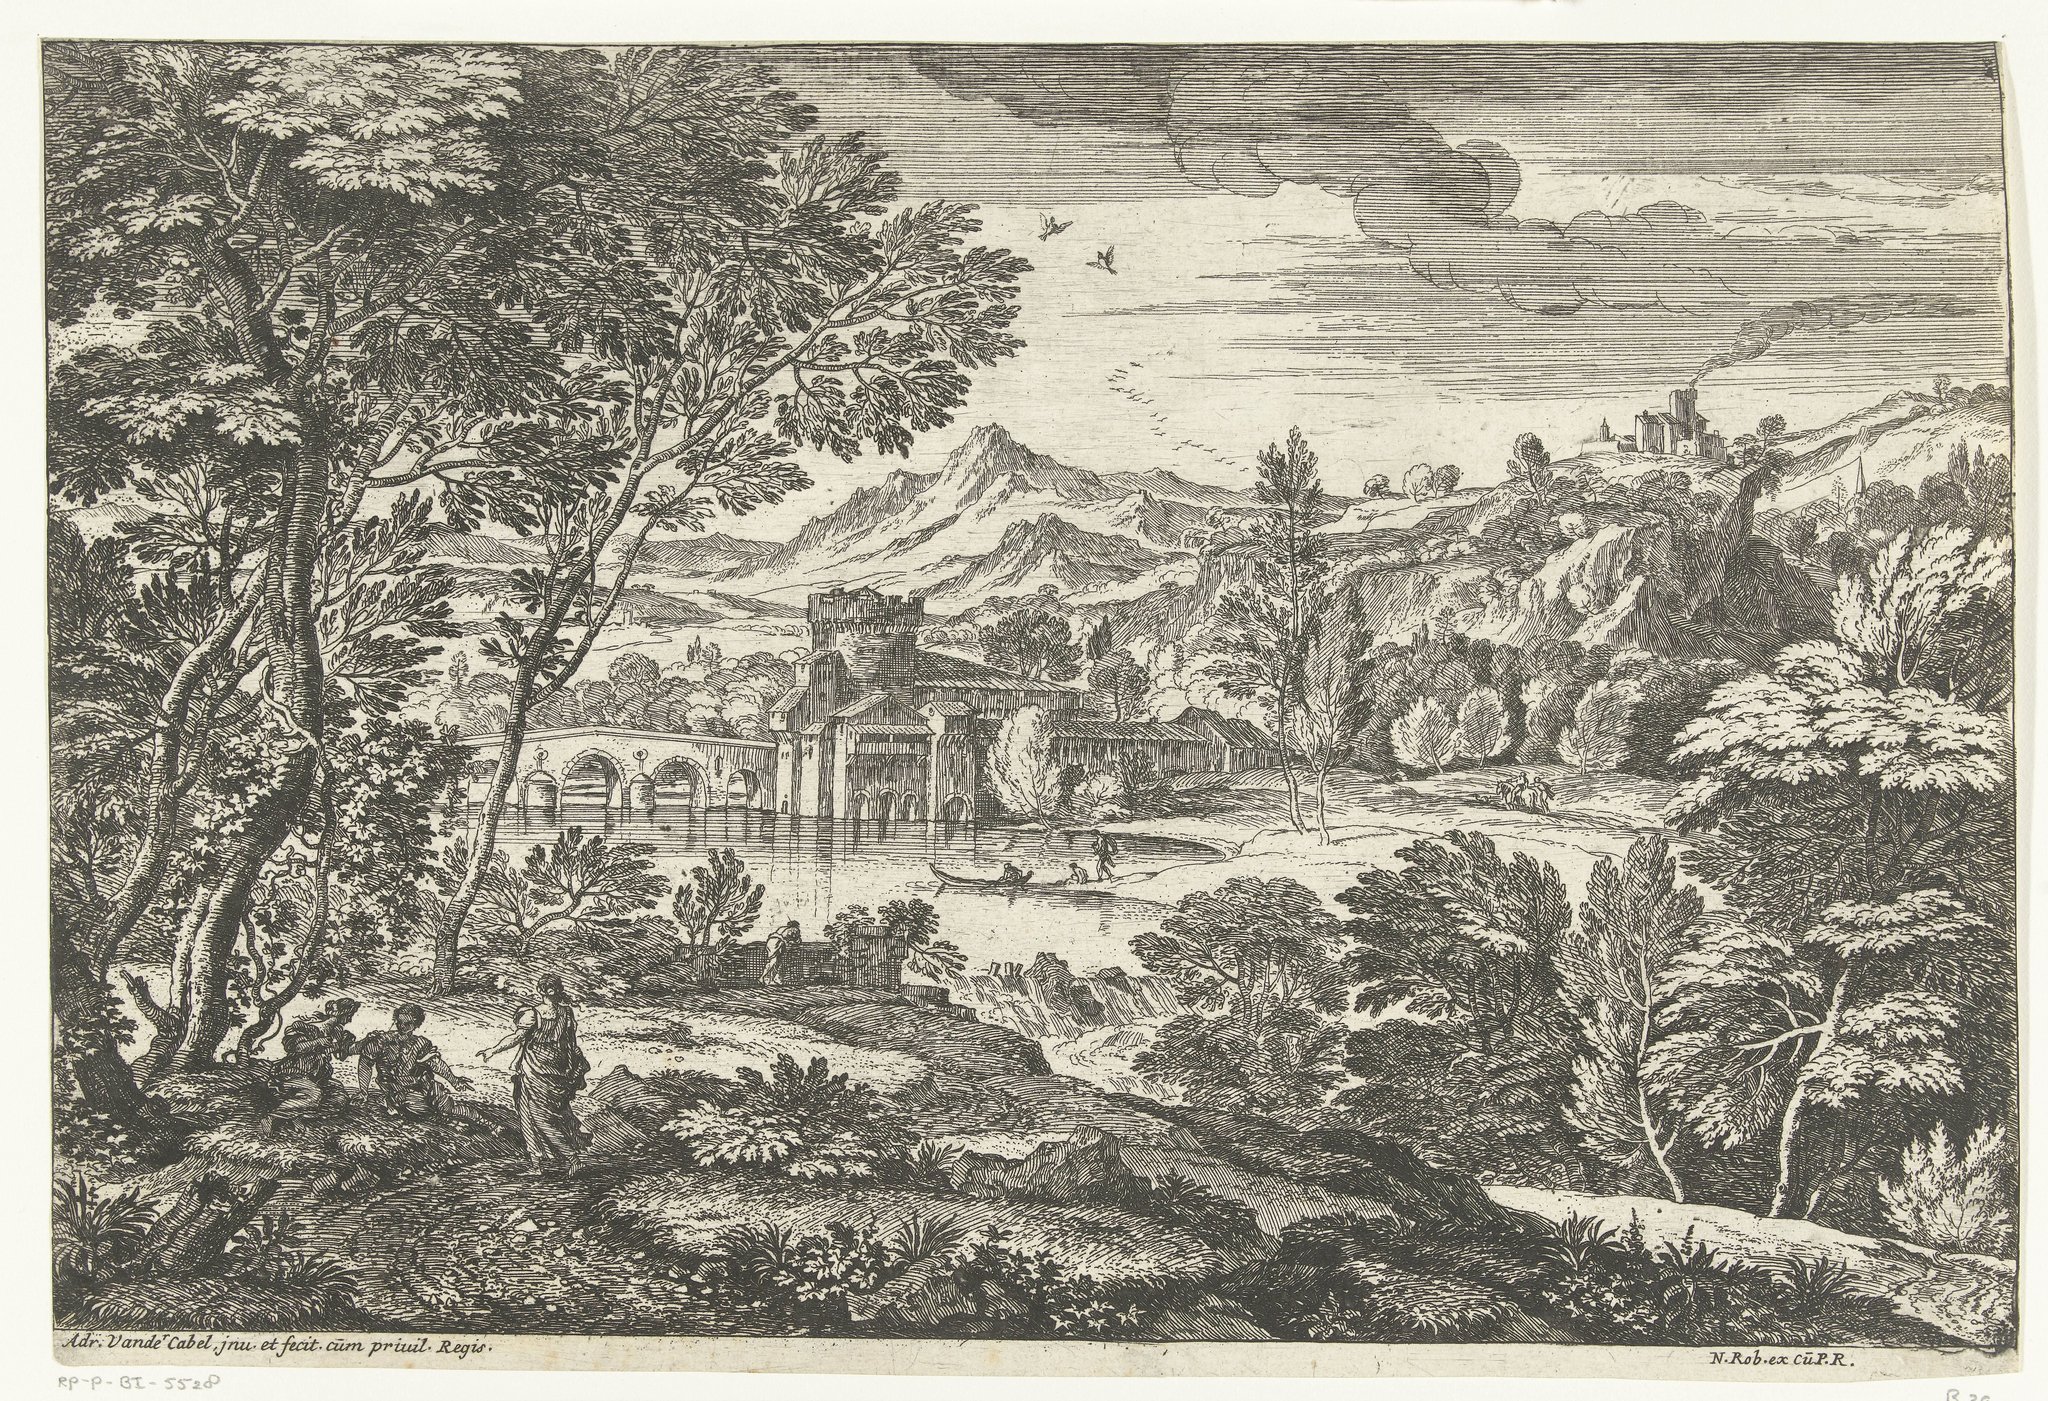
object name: print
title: Landschap met drie personen onder een boom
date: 1648-1705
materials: paper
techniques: etching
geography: france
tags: landscapes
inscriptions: collector's mark: Lugt 240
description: Landschap met staande vrouw, op pad, bij zittende man en vrouw onder een boom. Op de achtergrond een dorp met brug over een rivier. Tweede prent uit de serie van zes.